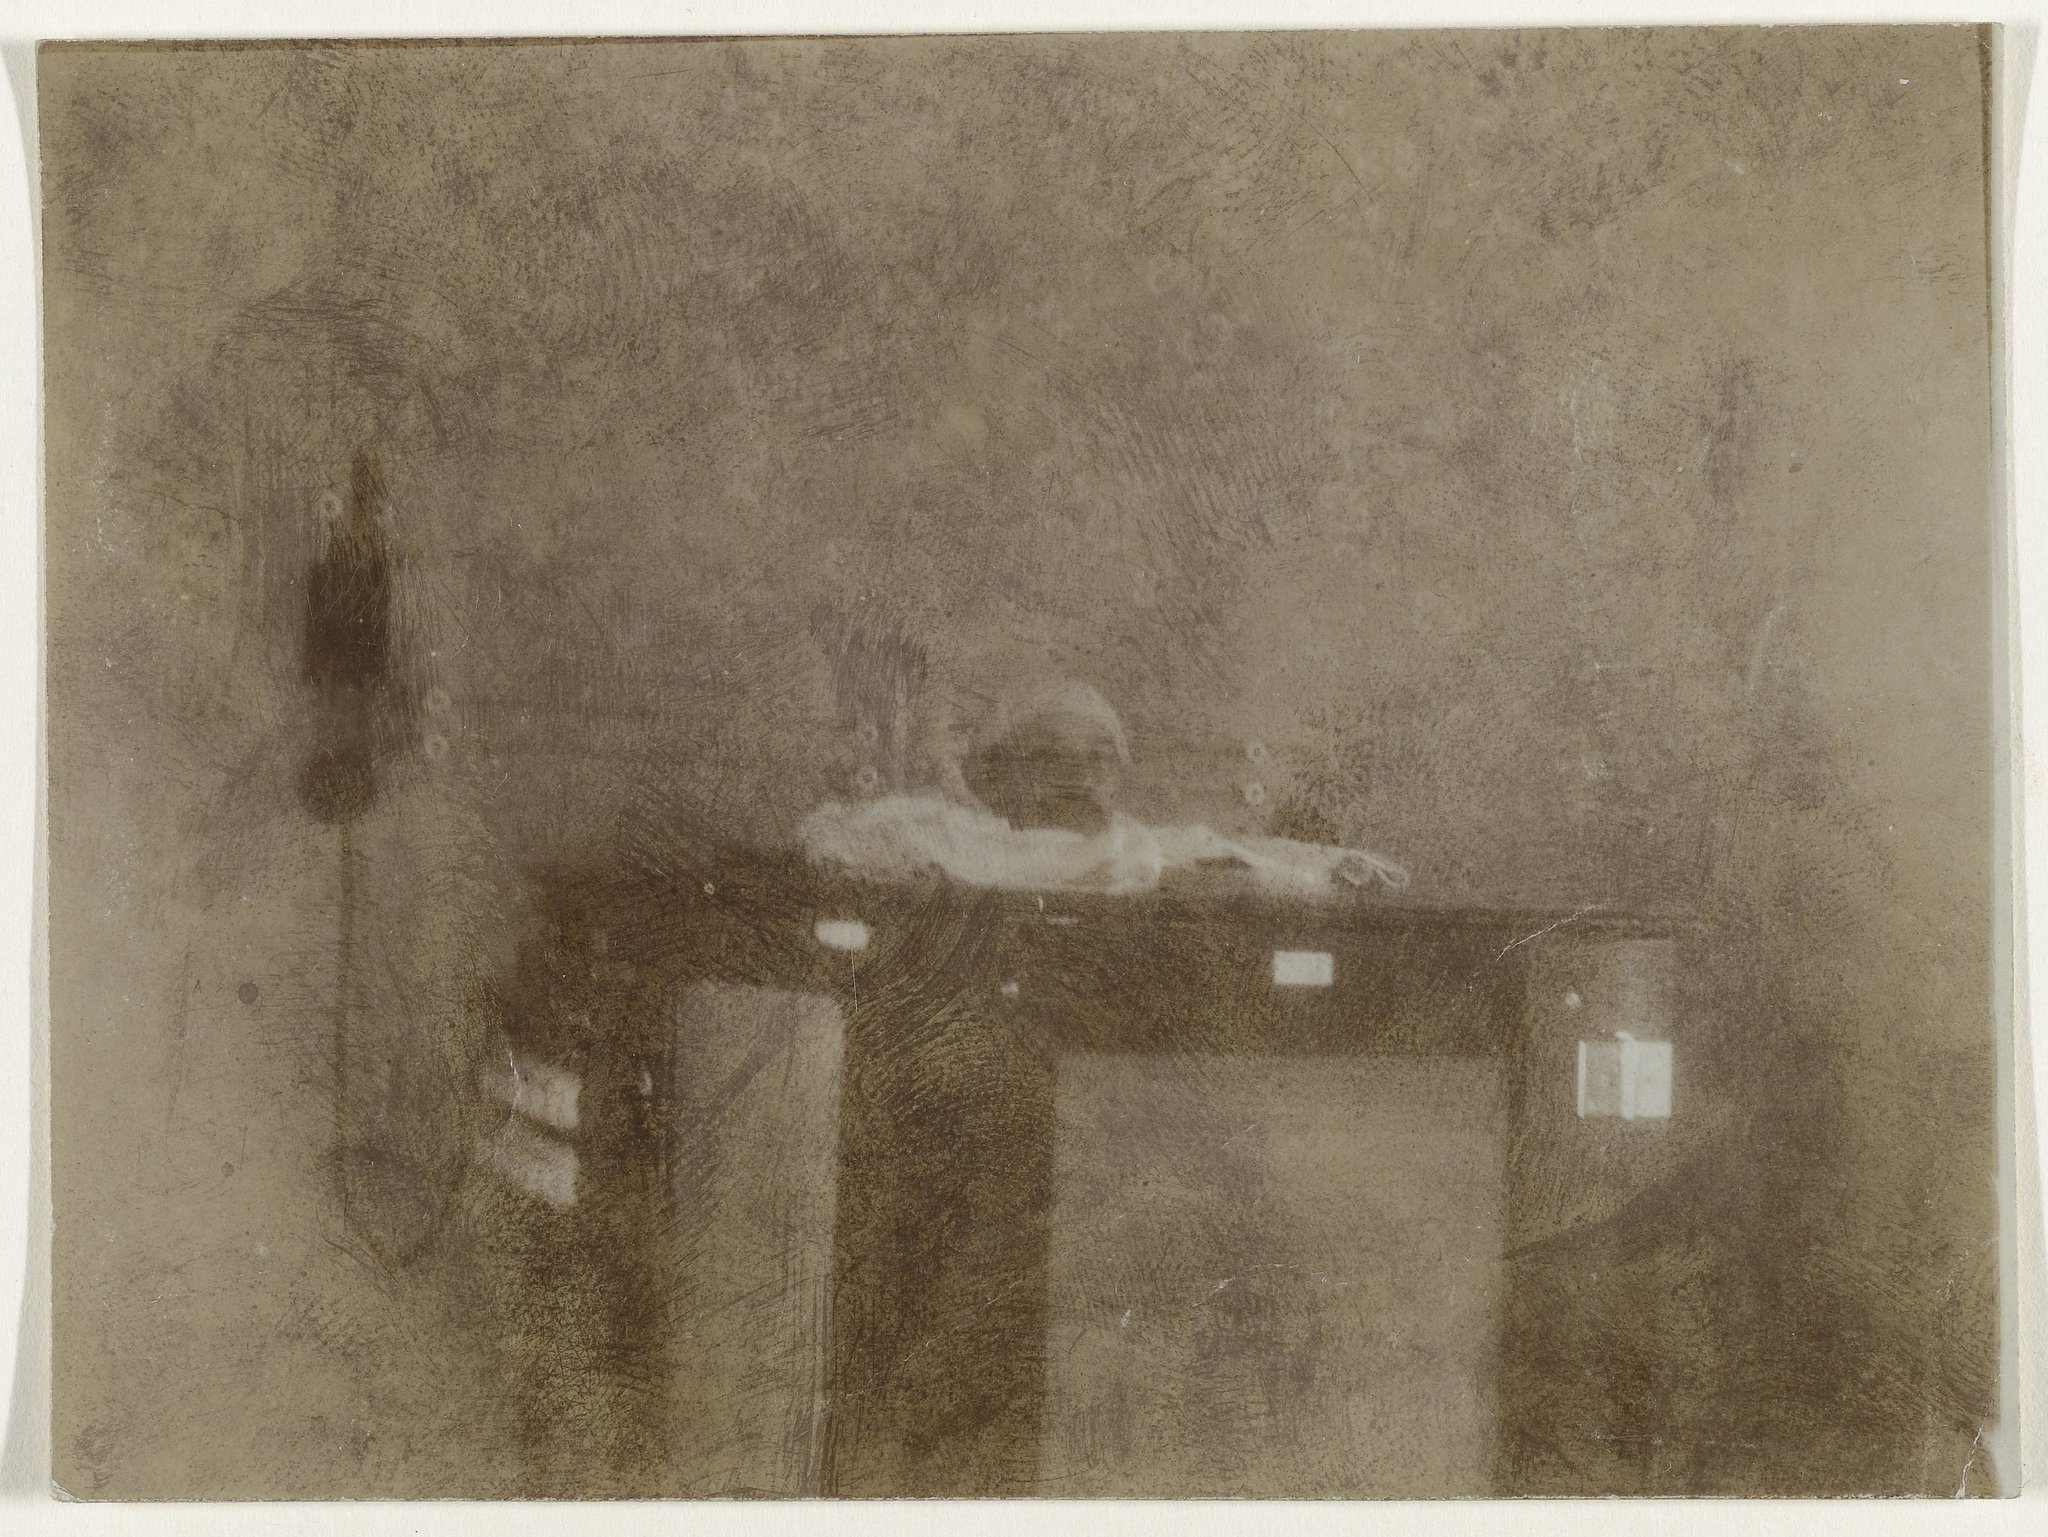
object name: photograph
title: Hoofd van een man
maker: Anonymous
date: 1900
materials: paper, photographic support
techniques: collodion silver print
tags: adult man